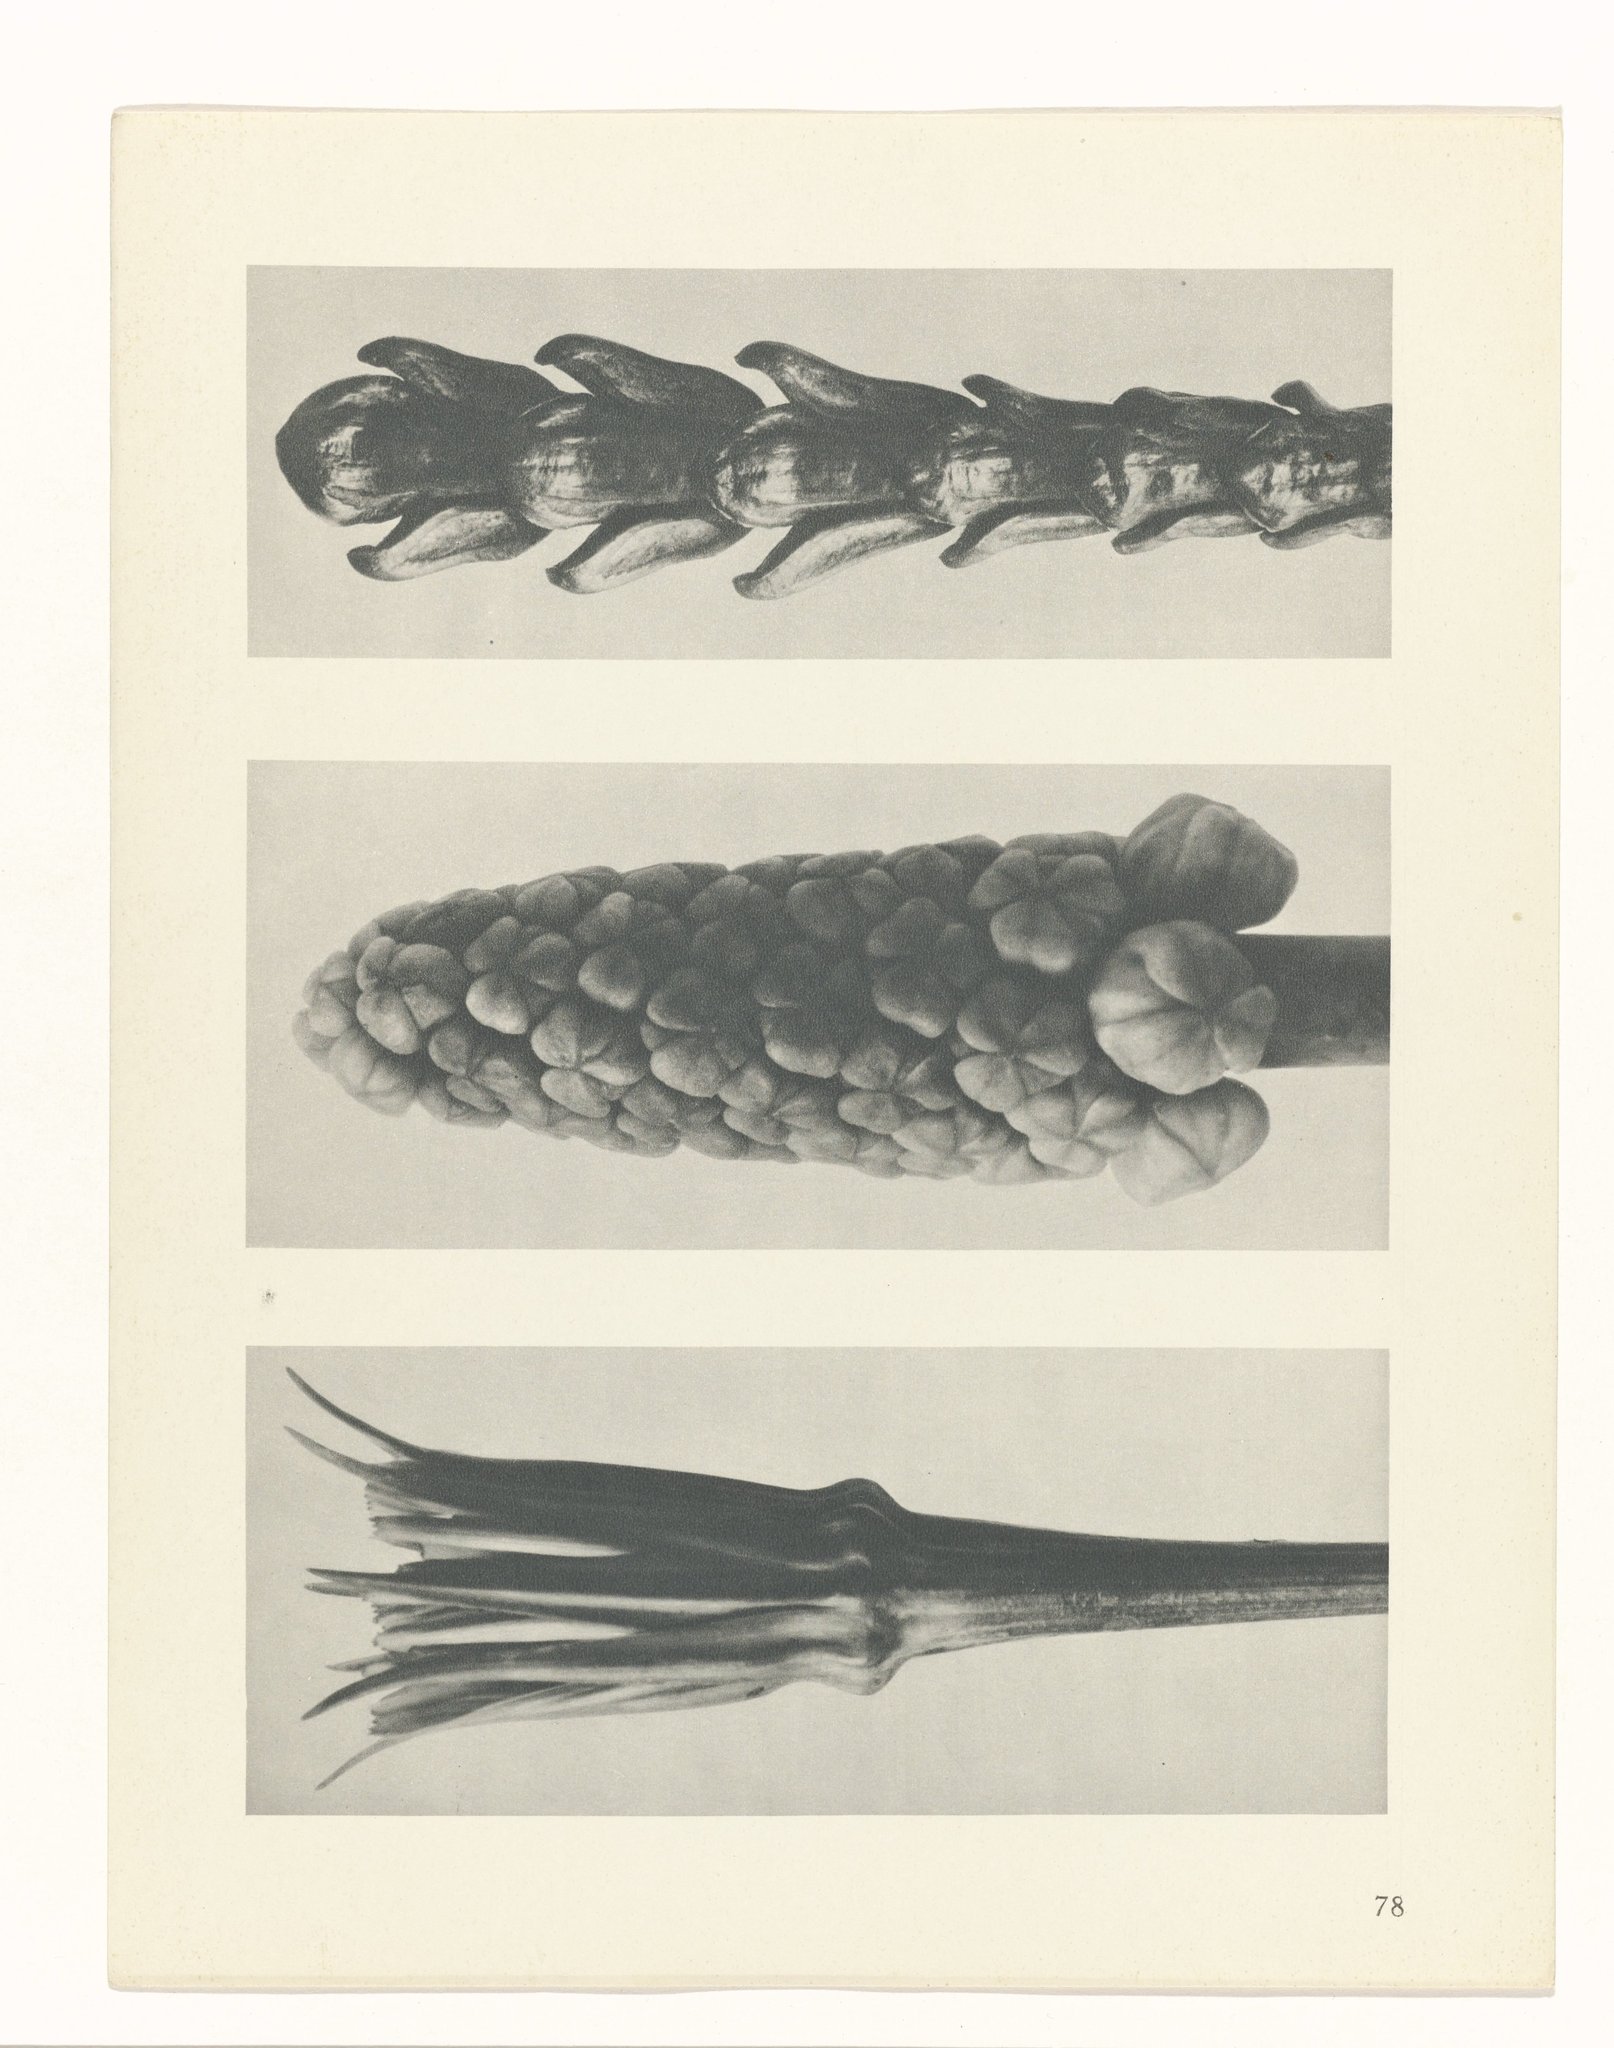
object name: photograph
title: Urformen der Kunst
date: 1928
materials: ink, paper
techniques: rotogravure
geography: berlin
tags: plants (in general)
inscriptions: number: ‘78’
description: facher Vergrößerung. Afkomstig uit losbladige uitgave.